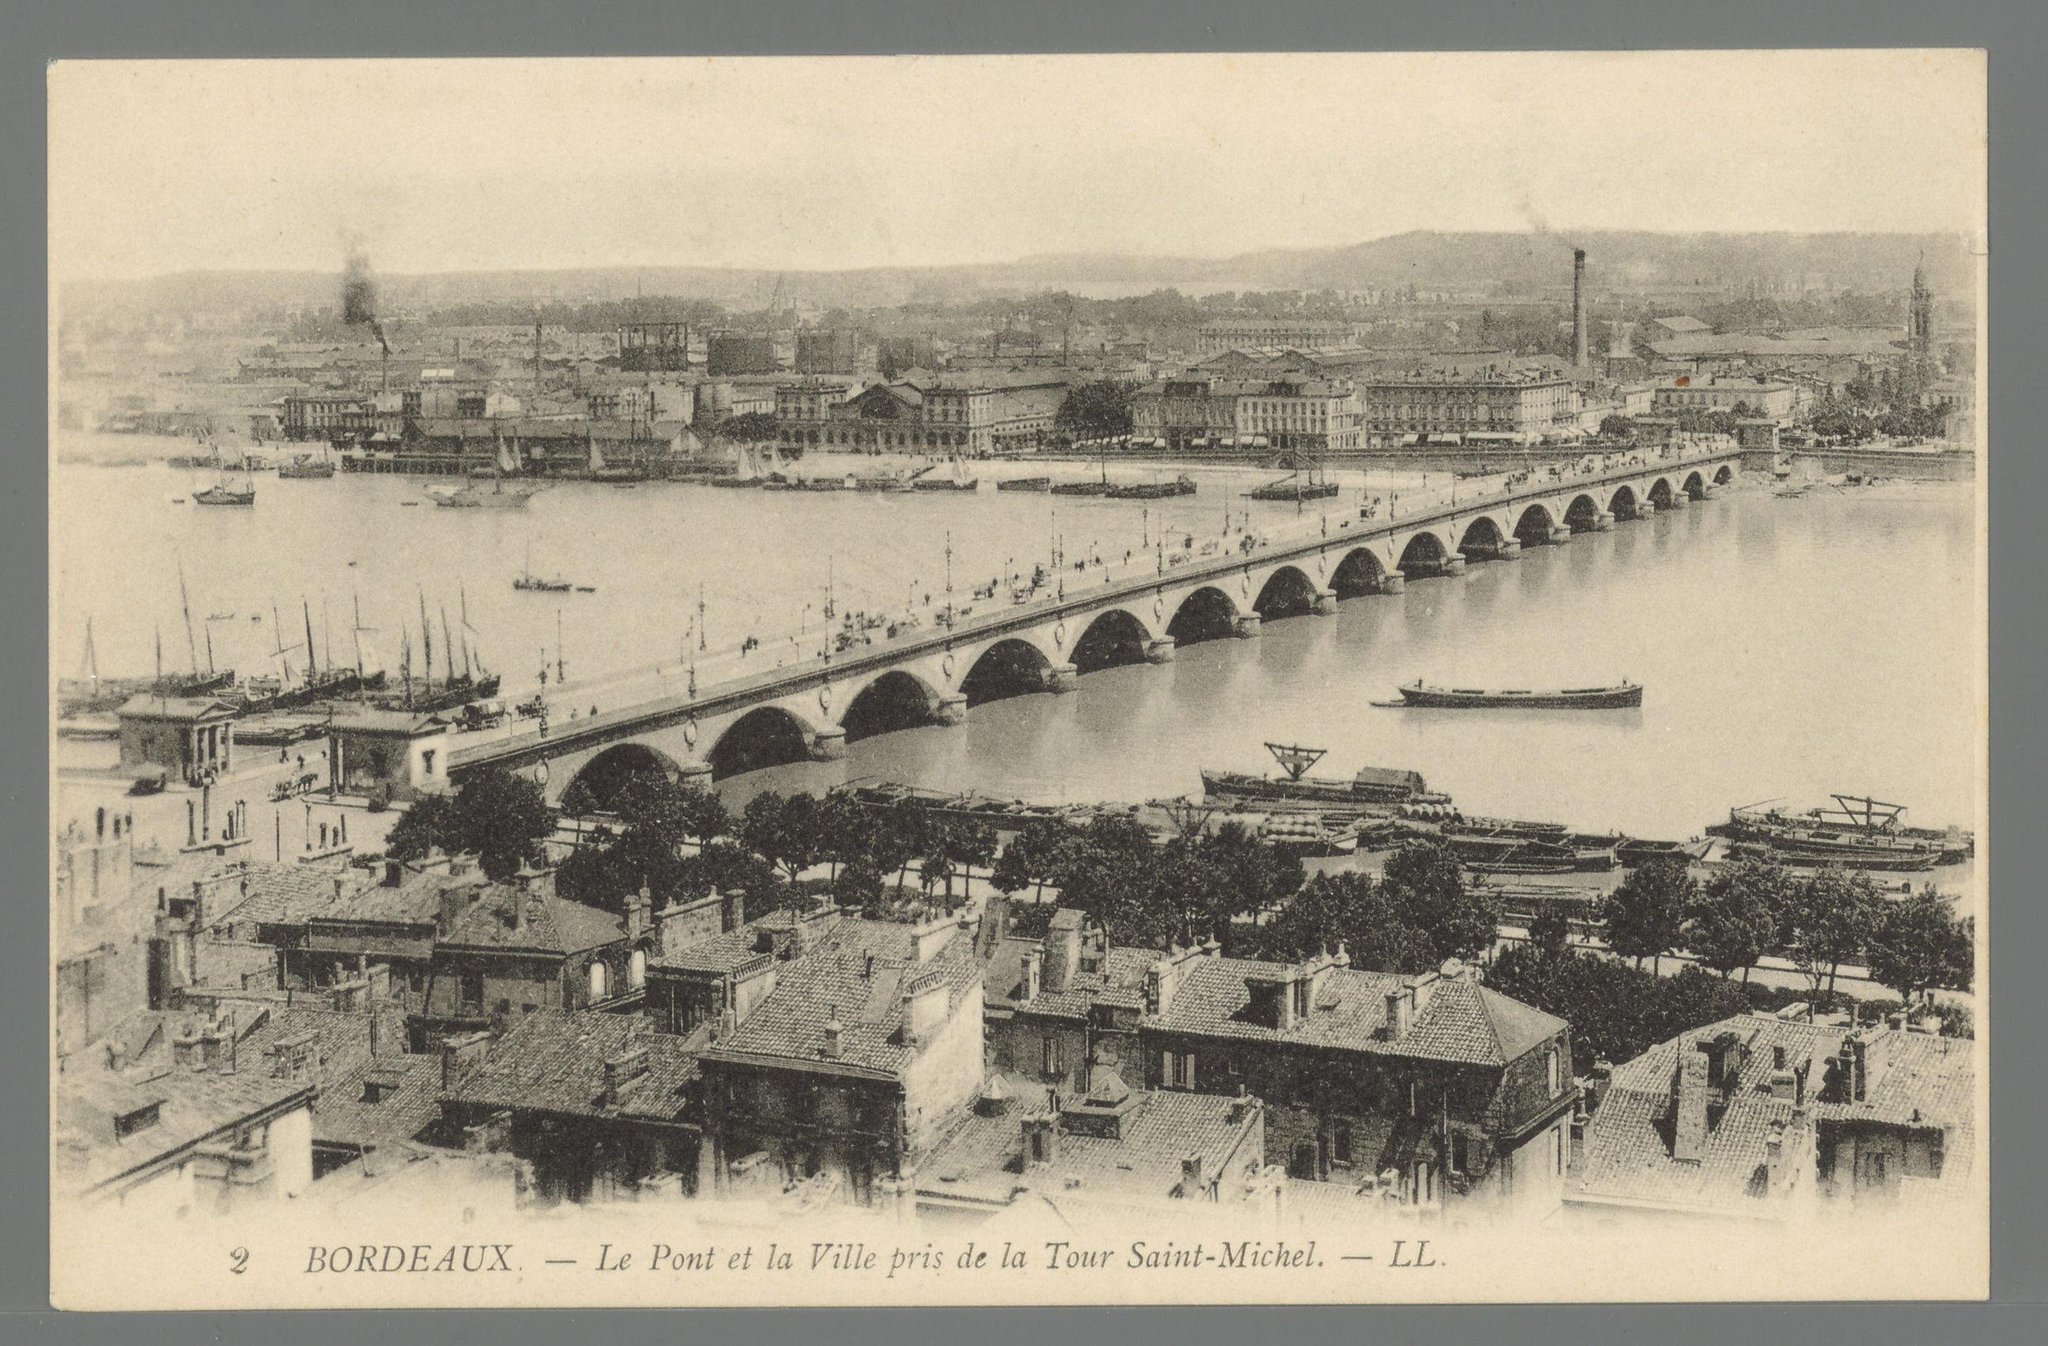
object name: photomechanical print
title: Bordeaux. Le Pont et la Ville pris de la Tour Saint-Michel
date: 1903-1920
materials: cardboard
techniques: photograph, writing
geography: paris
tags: city-view, and landscape with man-made constructions, river, bridge